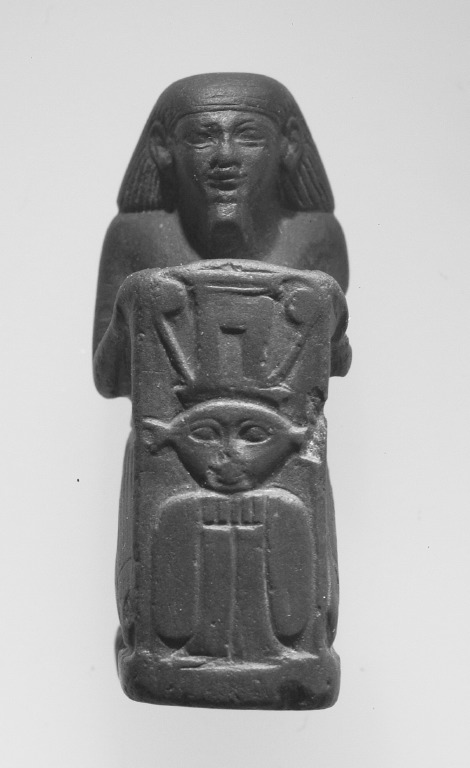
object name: statue, sistrophorous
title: Miniature Sistrophorous Statue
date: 690-610 BCE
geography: egypt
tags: men